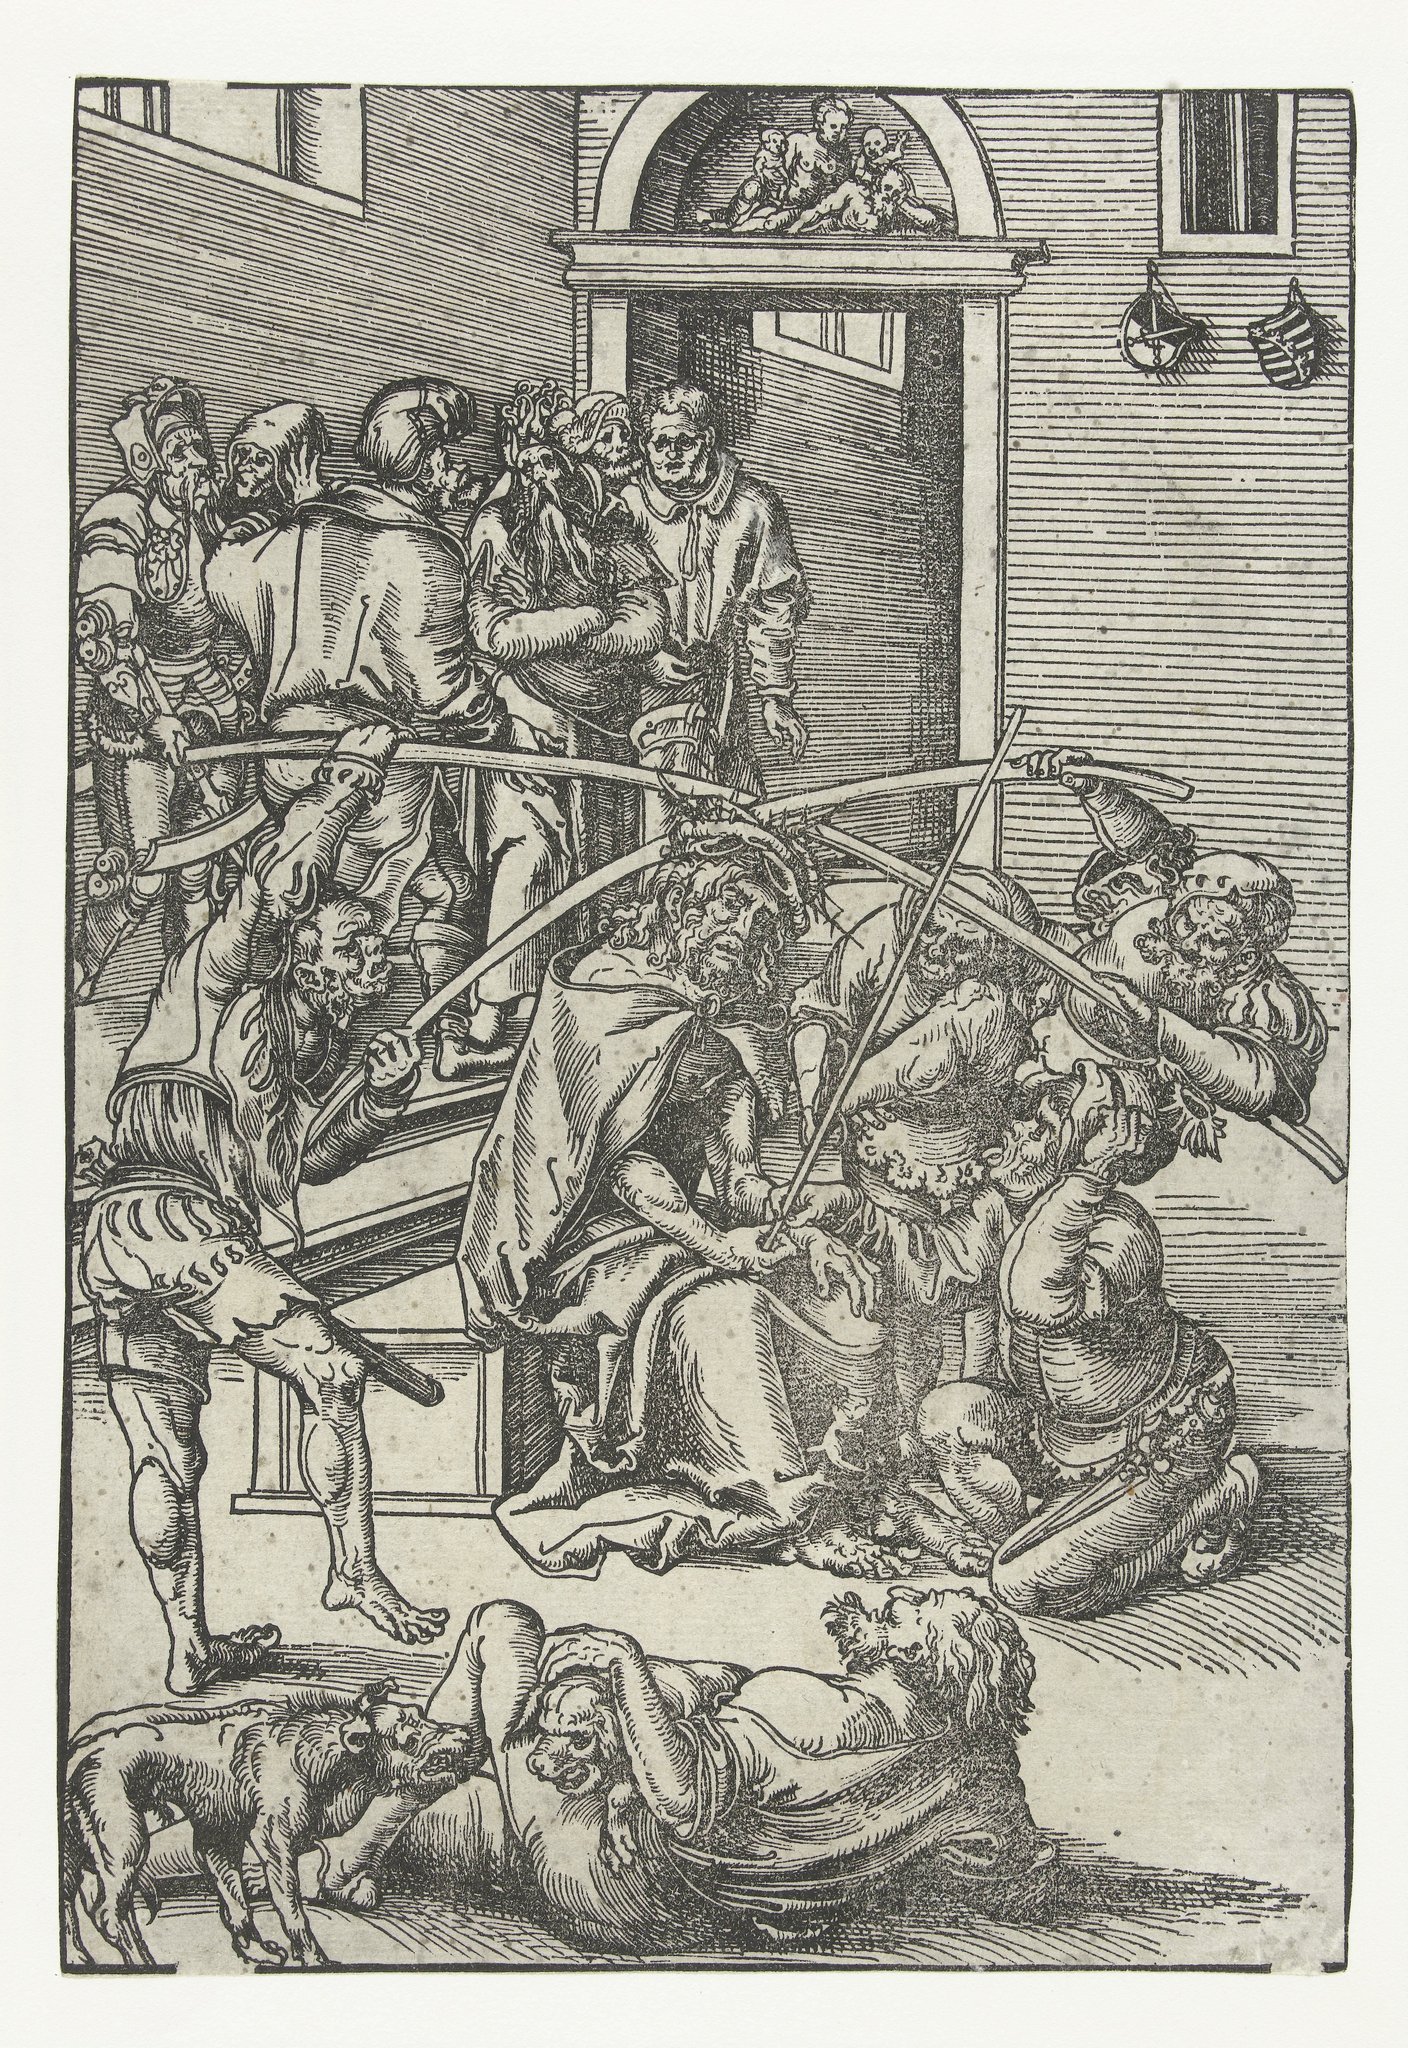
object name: print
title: Passie van Christus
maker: lucas cranach (i)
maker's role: draughtsman, print maker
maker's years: 1472-1553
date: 1509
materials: paper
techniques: woodcut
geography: germany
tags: the crowning with thorns: soldiers with sticks place a thorny crown on christ's head and give him a reed (matthew 27:27-31; mark 15:16-20; john 19:2-3)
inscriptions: collector's mark: Lugt 240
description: De soldaten van Pilatus hebben de zittende Christus gekroond met een doornenkroon, hem een mantel aangetrokken en een scepter in de hand gegeven. Twee soldaten drukken met twee stokken de kroon met grote doorns stevig op het hoofd van Christus. Een man knielt voor hem terwijl hij spottend zijn tong uitsteekt, een andere man ligt languit op de grond met twee honden terwijl hij lachend toekijkt. Op de achtergrond staan verschillende mannen van het gerechtshof. Tegen de wand rechtsboven hangen het keurvorstelijk en hertogelijk wapen van Saksen op twee schilden.